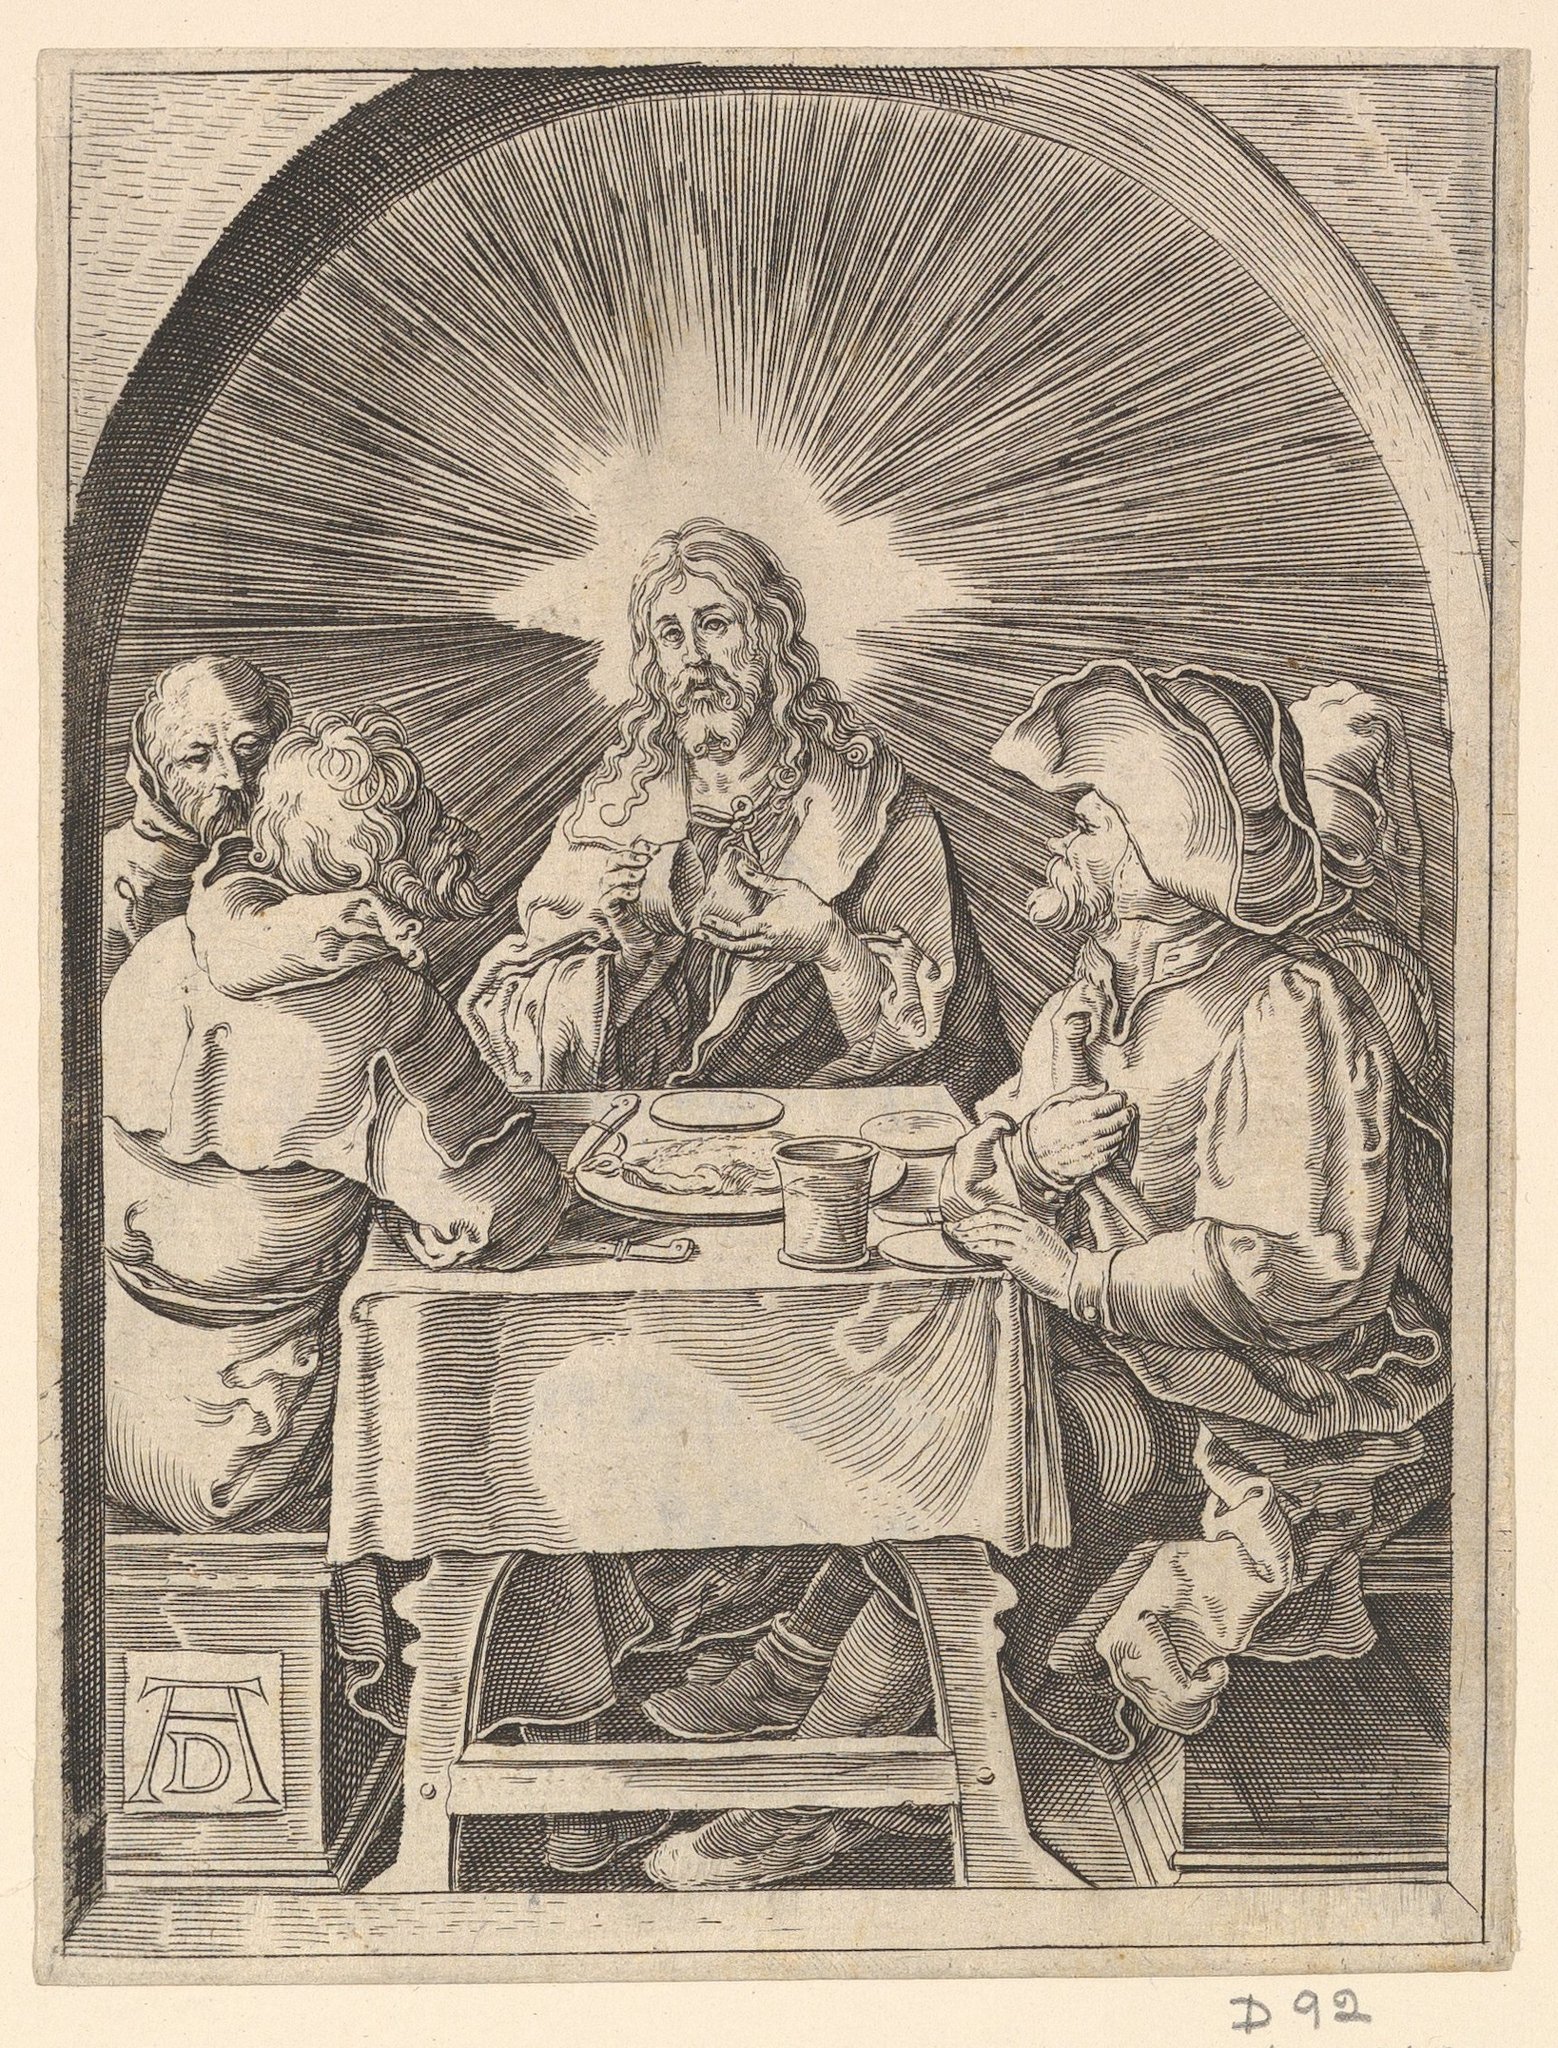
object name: print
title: Engraved copies of The Little Passion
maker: albrecht dürer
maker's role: artist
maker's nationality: german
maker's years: 1471-1528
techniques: engraving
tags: men,christ